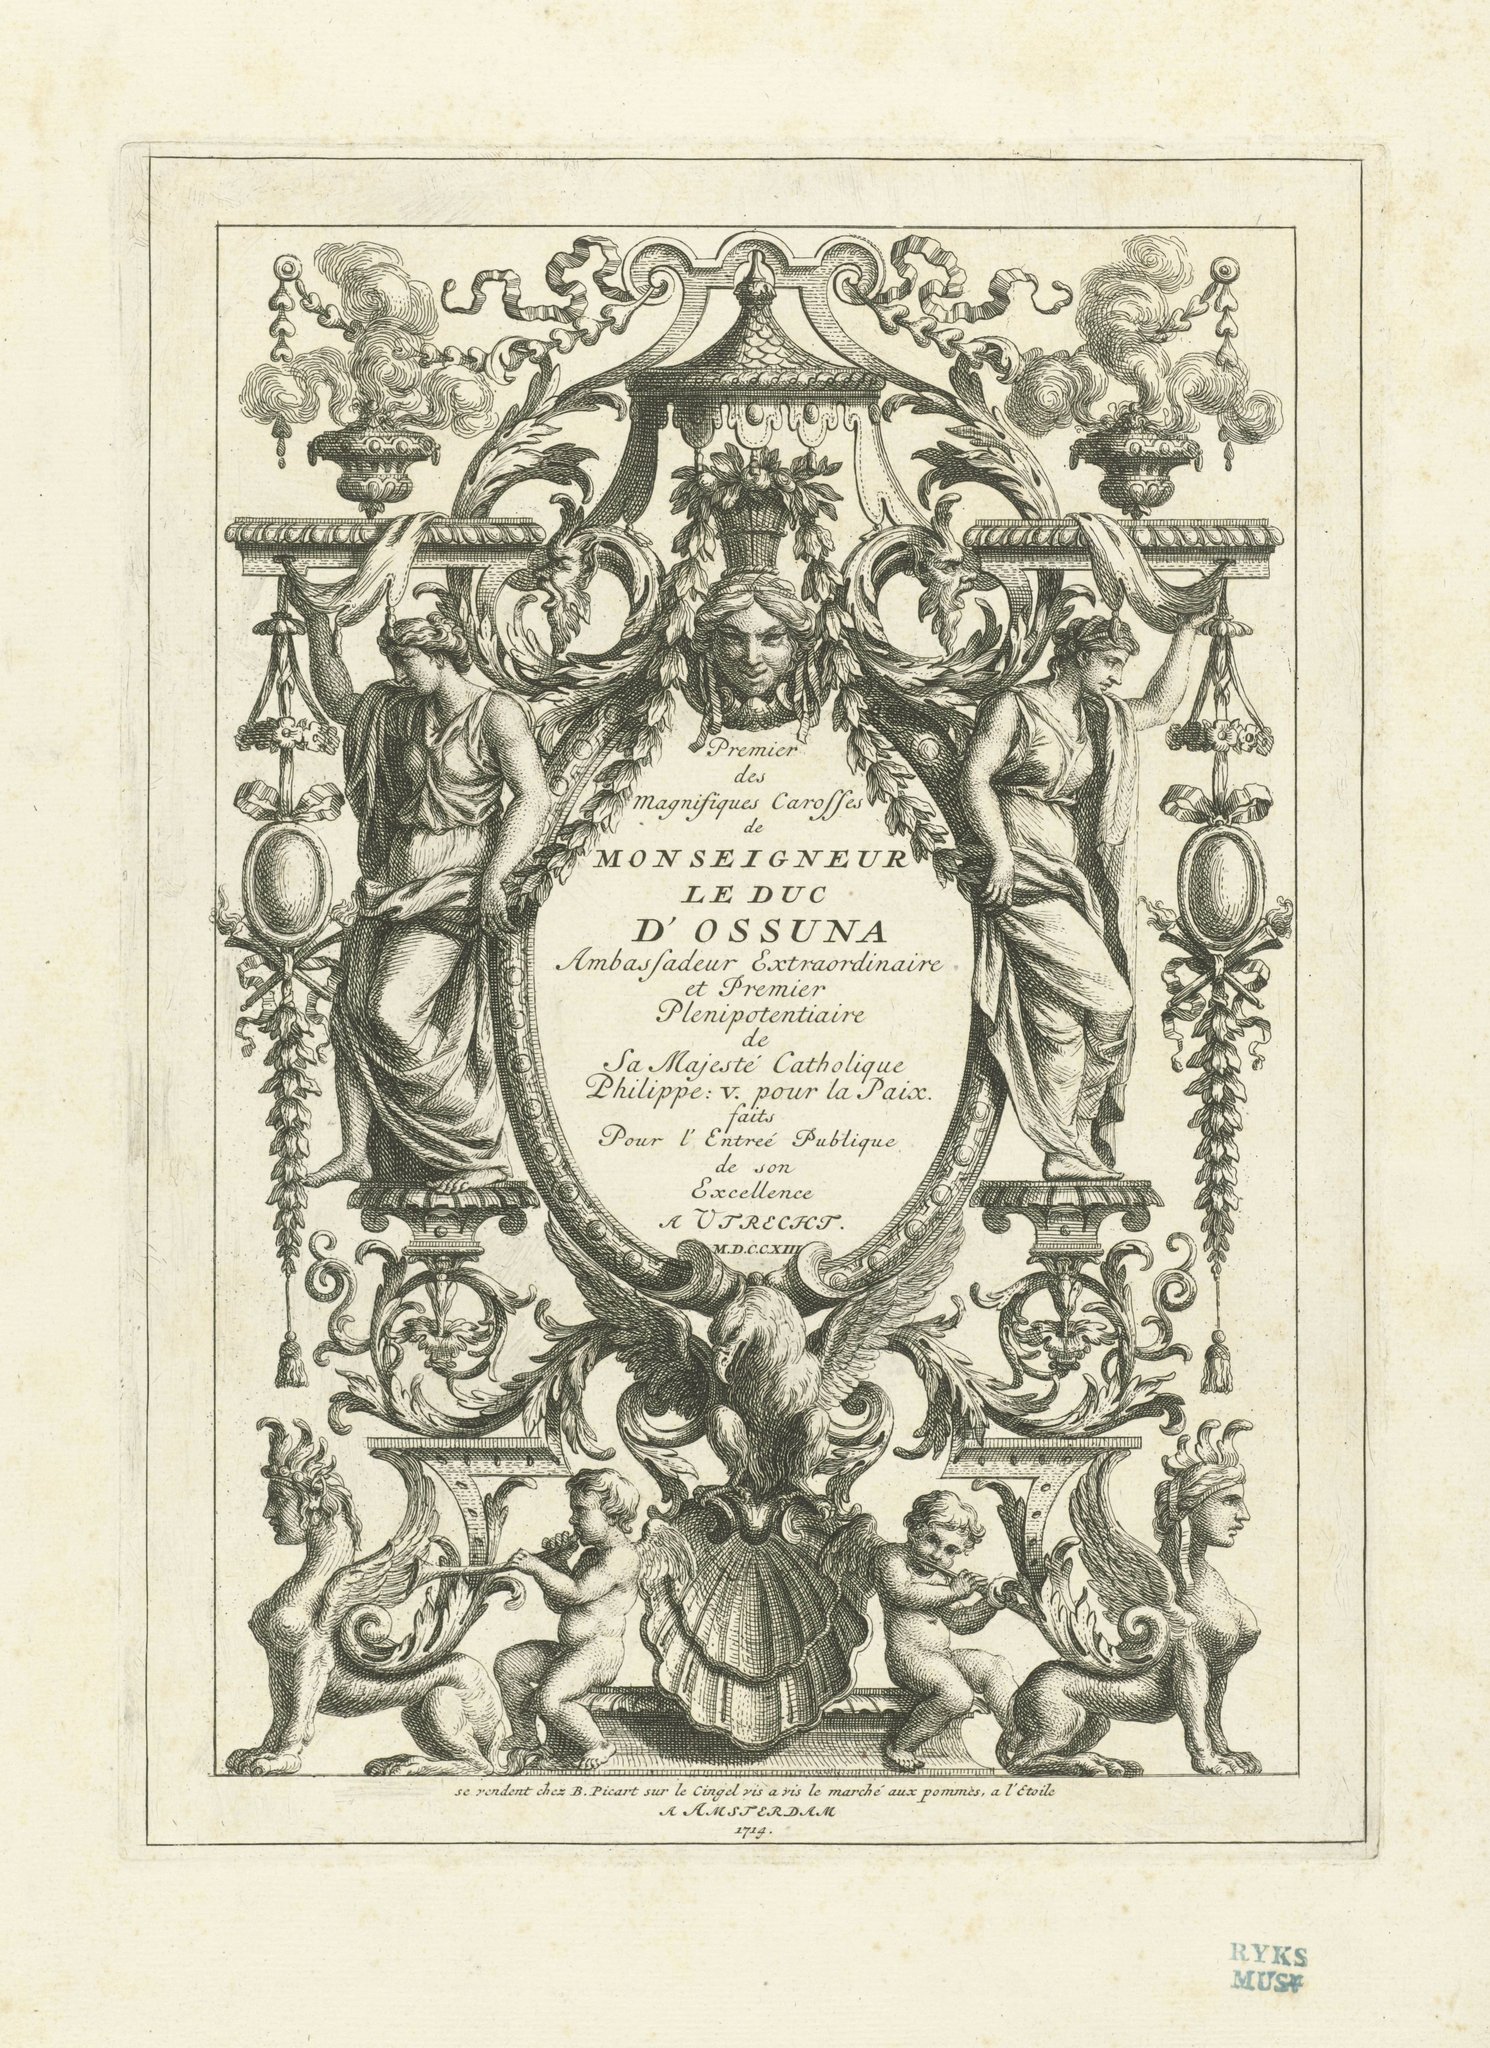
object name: titelprent, frontispice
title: Titelprent voor de serie platen van de statiekoets van de hertog van Ossuna, 1713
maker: bernard picart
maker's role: draughtsman, print maker, publisher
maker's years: 1673-1733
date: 1714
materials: paper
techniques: engraving, etching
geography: amsterdam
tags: ornaments ~ art, utrecht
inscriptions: collector's mark: Lugt 2165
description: Titel in een rijk versierde ornamentele omlijsting met twee vrouwenfiguren, engelen, sfinxen en bladwerk. Titelprent voor de serie platen van de statiekoets van de Spaanse gezant de hertog van Ossuna, gebruikt bij zijn openbare intocht in Utrecht voor de vredesonderhandelingen in 1713.